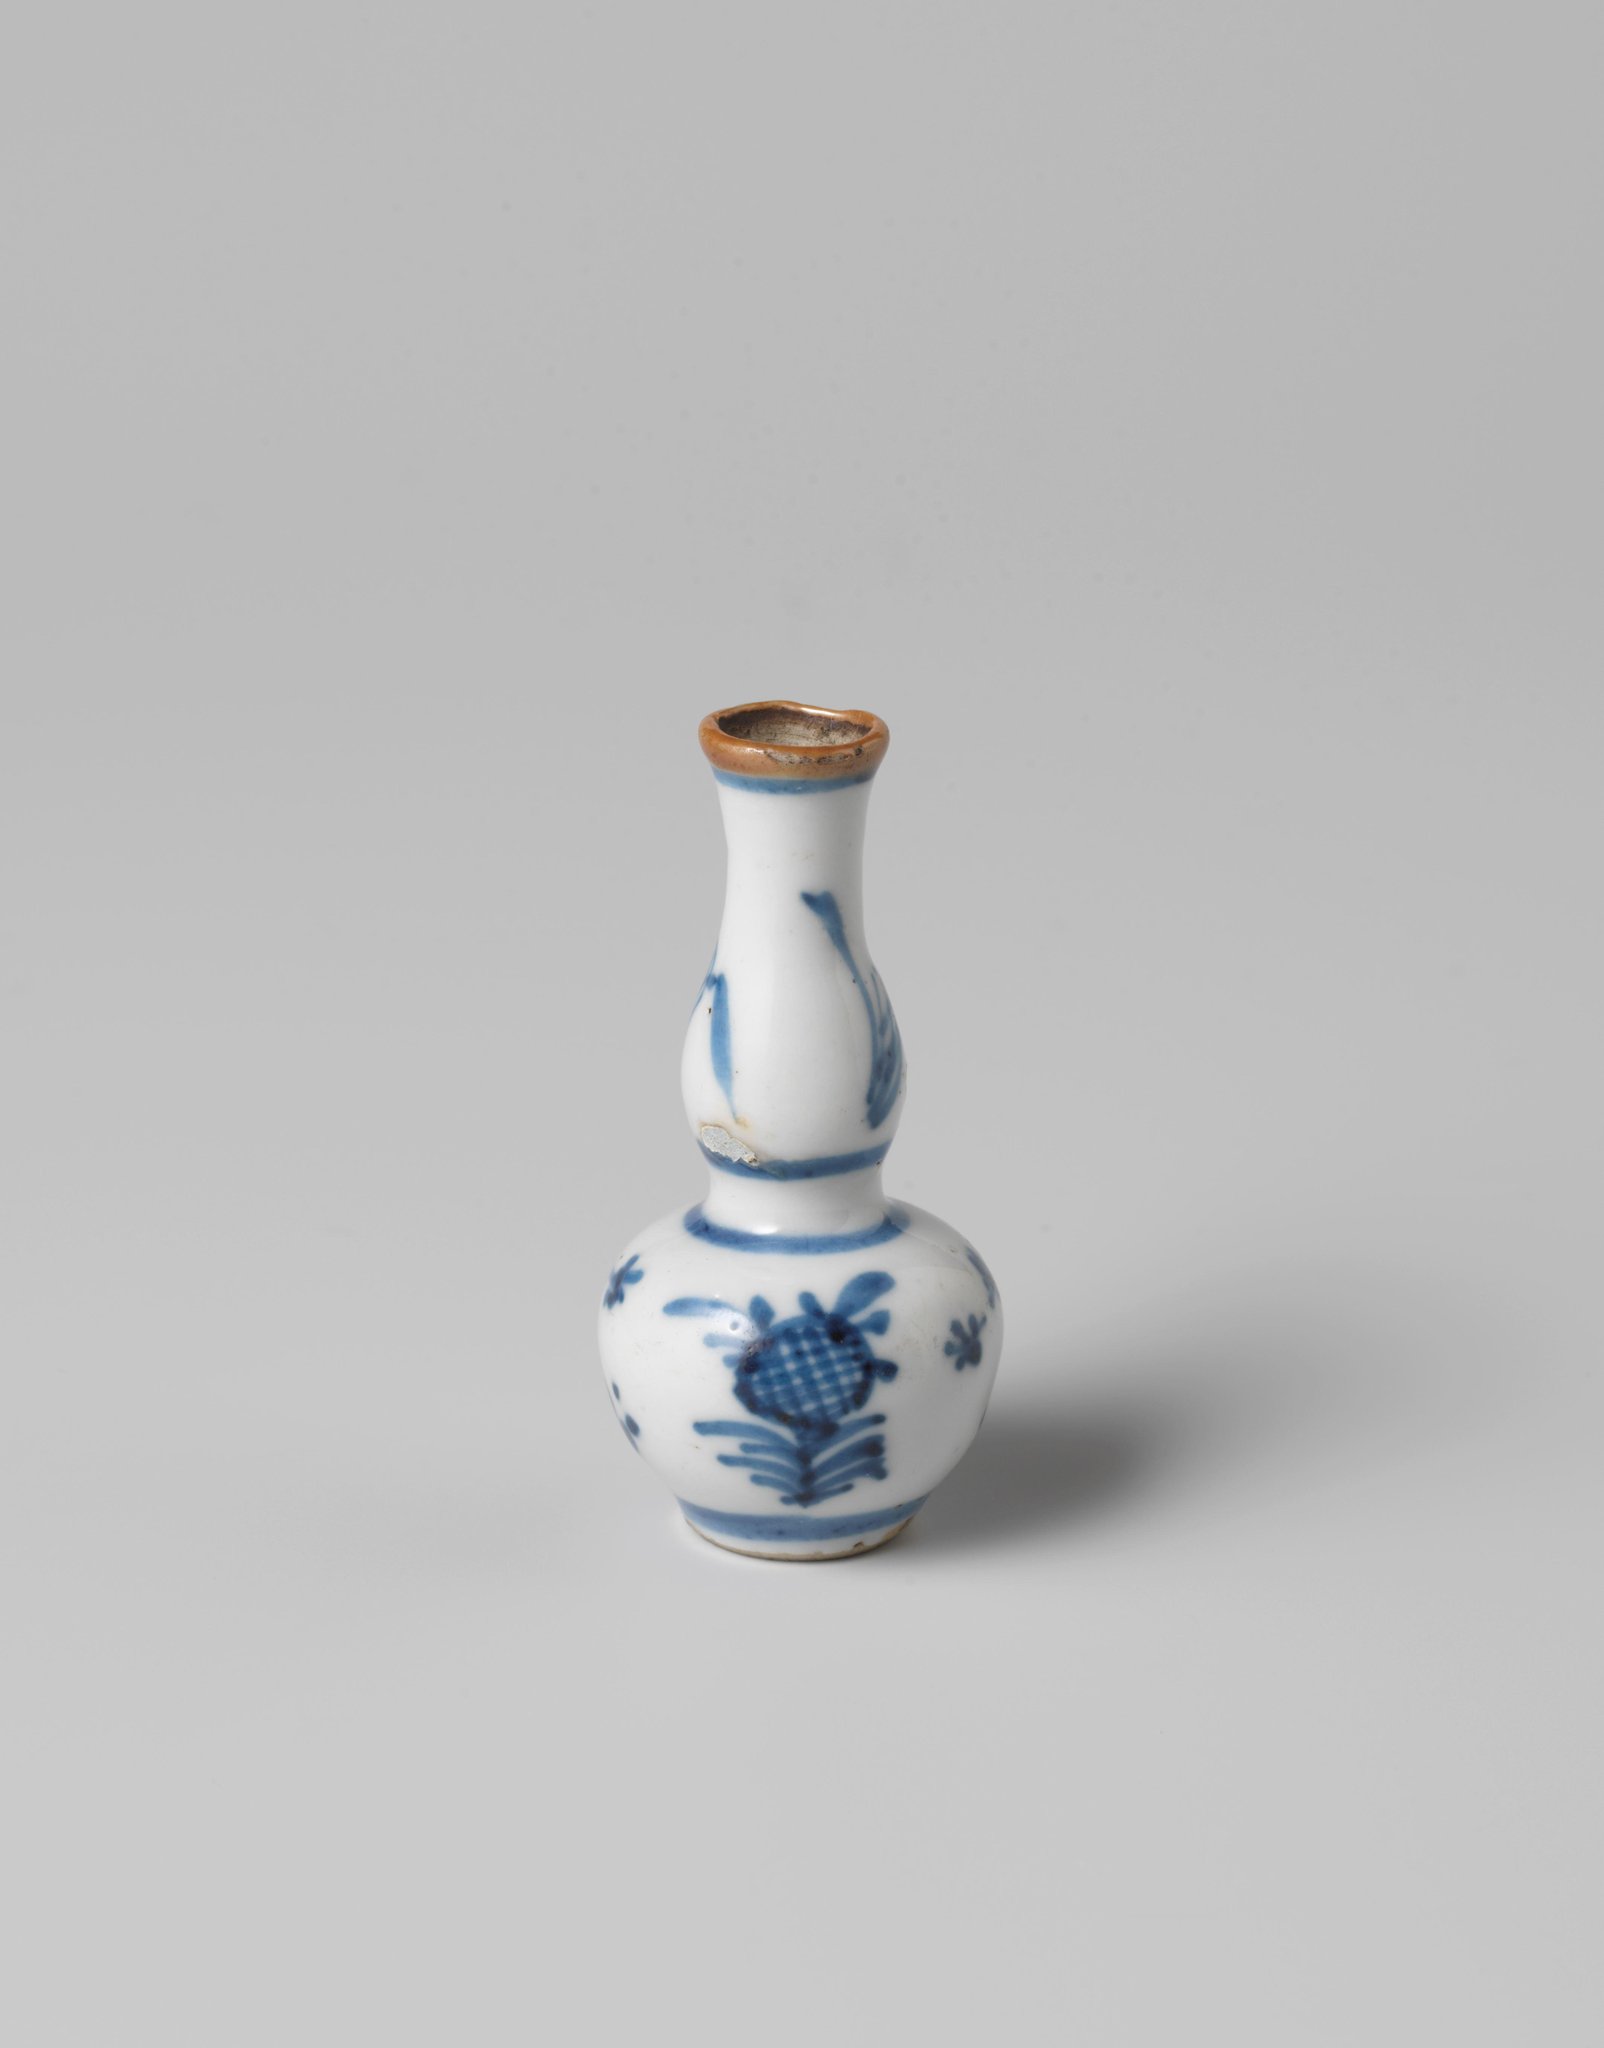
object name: vase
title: Miniature double-gourd-shaped vase with flowering plants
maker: Anonymous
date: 1675-1724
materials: cobalt, glaze, paint, porcelain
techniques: firing, turning, vitrification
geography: china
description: Miniatuur vaas van porselein met kalebasvormig lichaam, beschilderd in onderglazuur blauw. Op de buik en de hals tweemaal een bloeiende plant; de rand met een bruin glazuur. Blauw-wit.